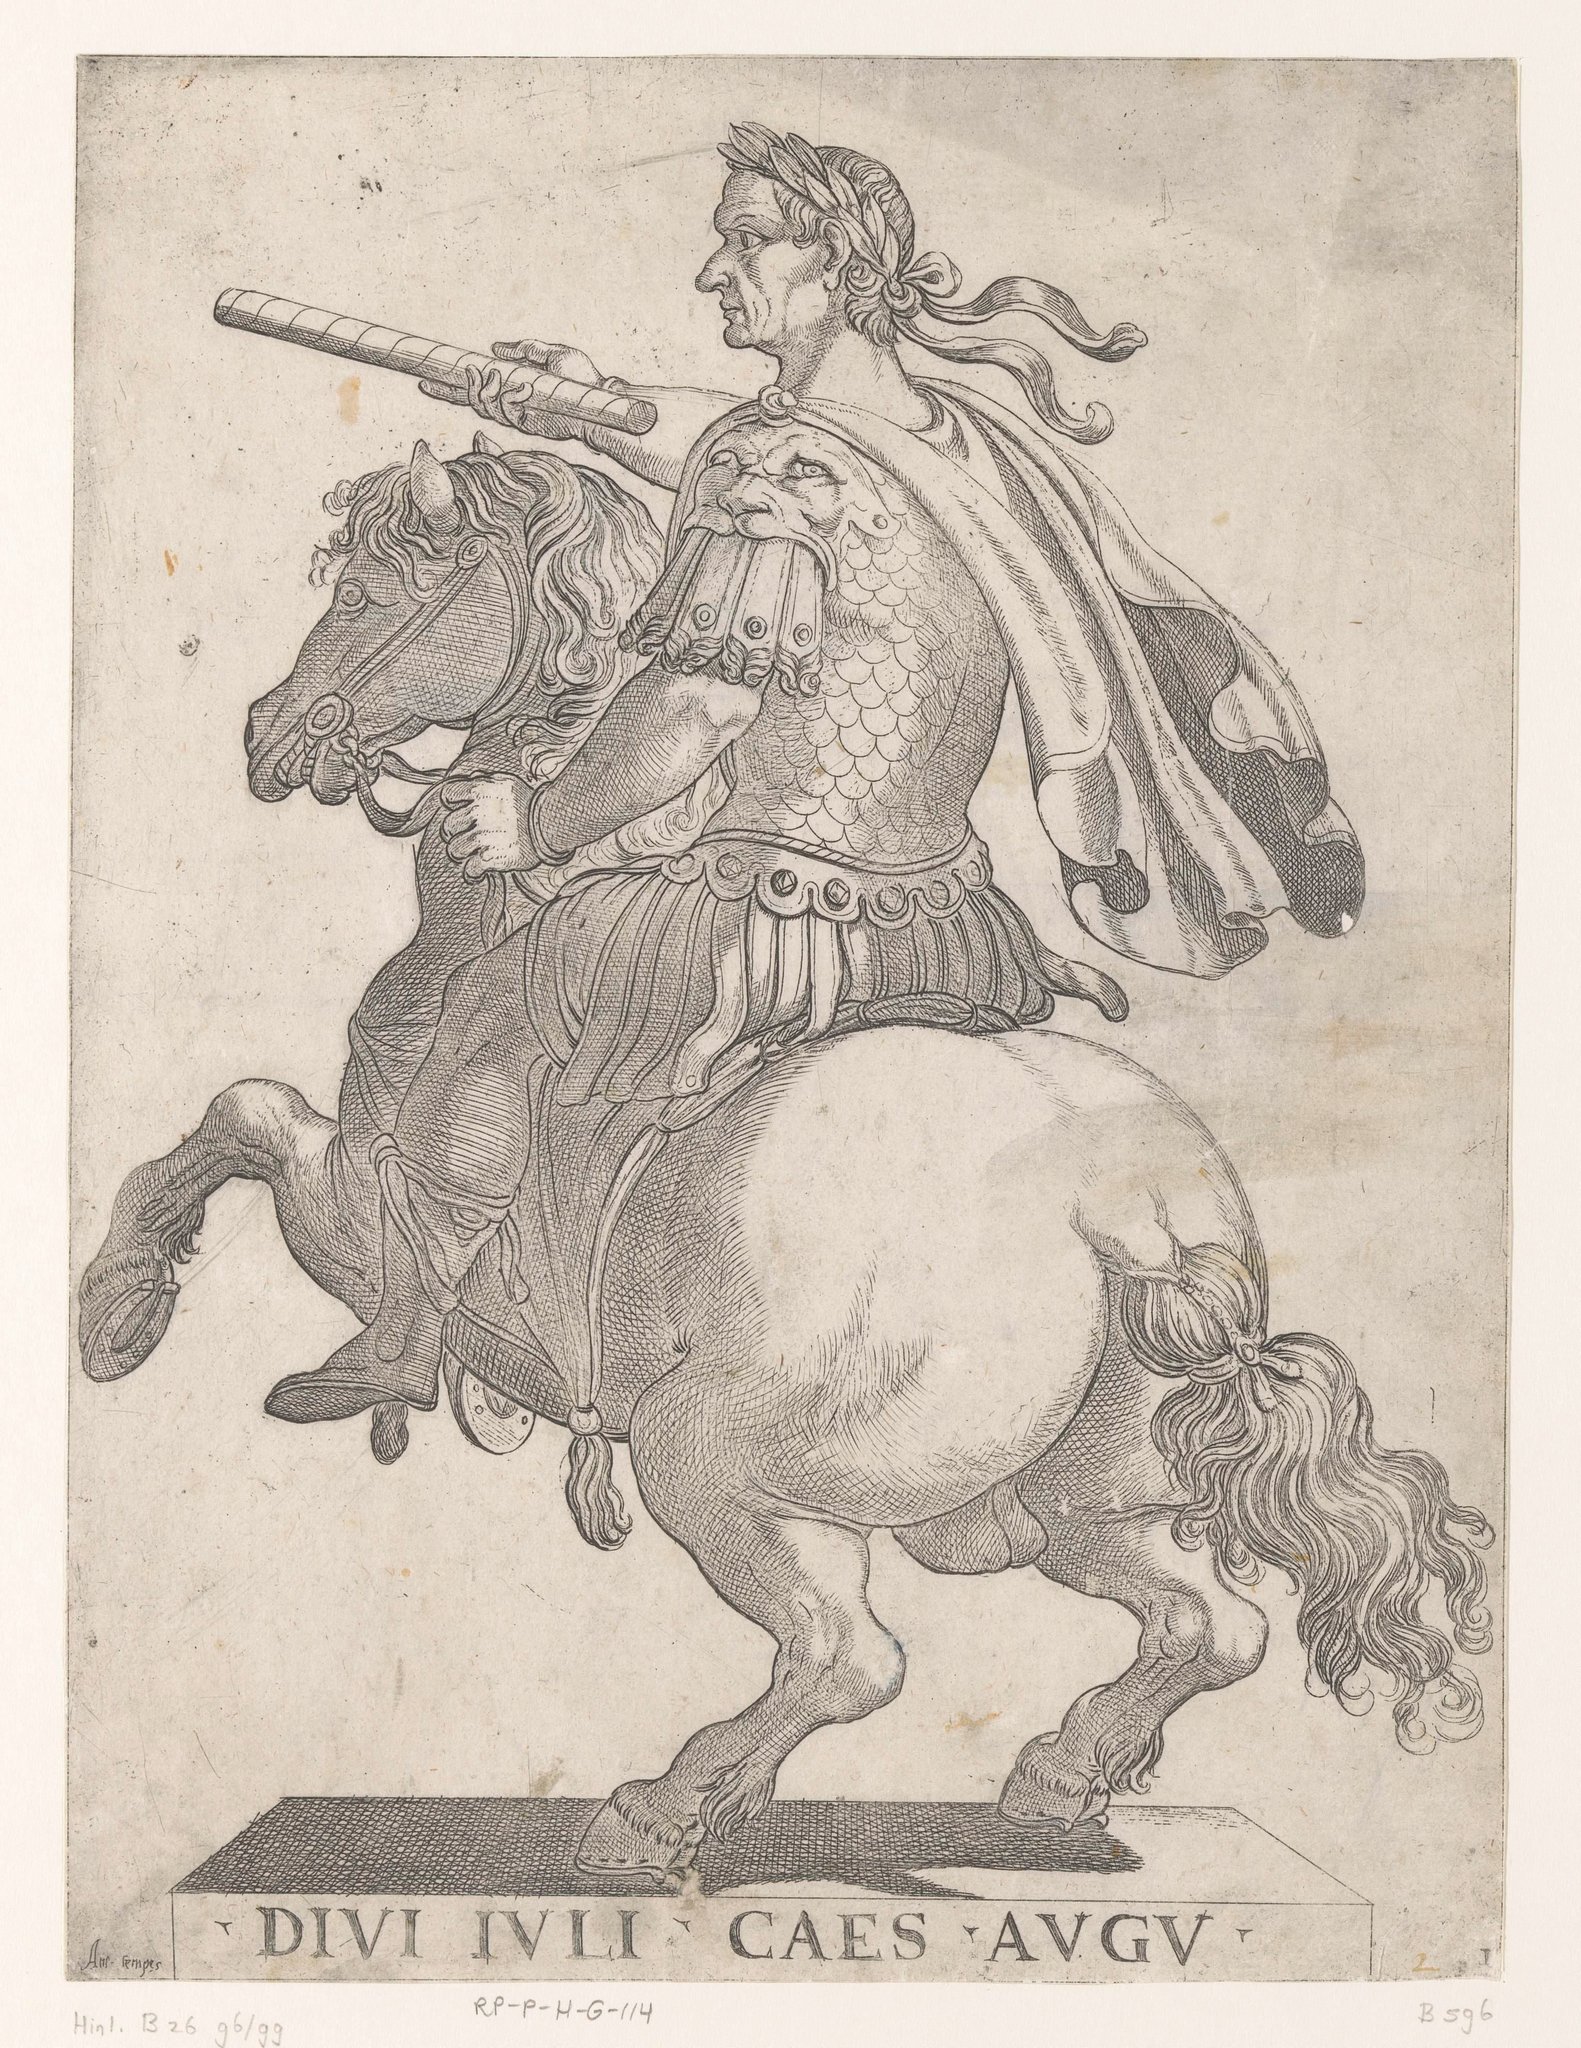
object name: print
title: XII caesares in equestri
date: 1600-1630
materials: paper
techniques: etching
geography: rome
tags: portrait of caesar, equestrian statue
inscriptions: collector's mark: ‘Hinloopen’, number: ‘2’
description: Titelprent bij een reeks van twaalf prenten van Romeinse keizers.